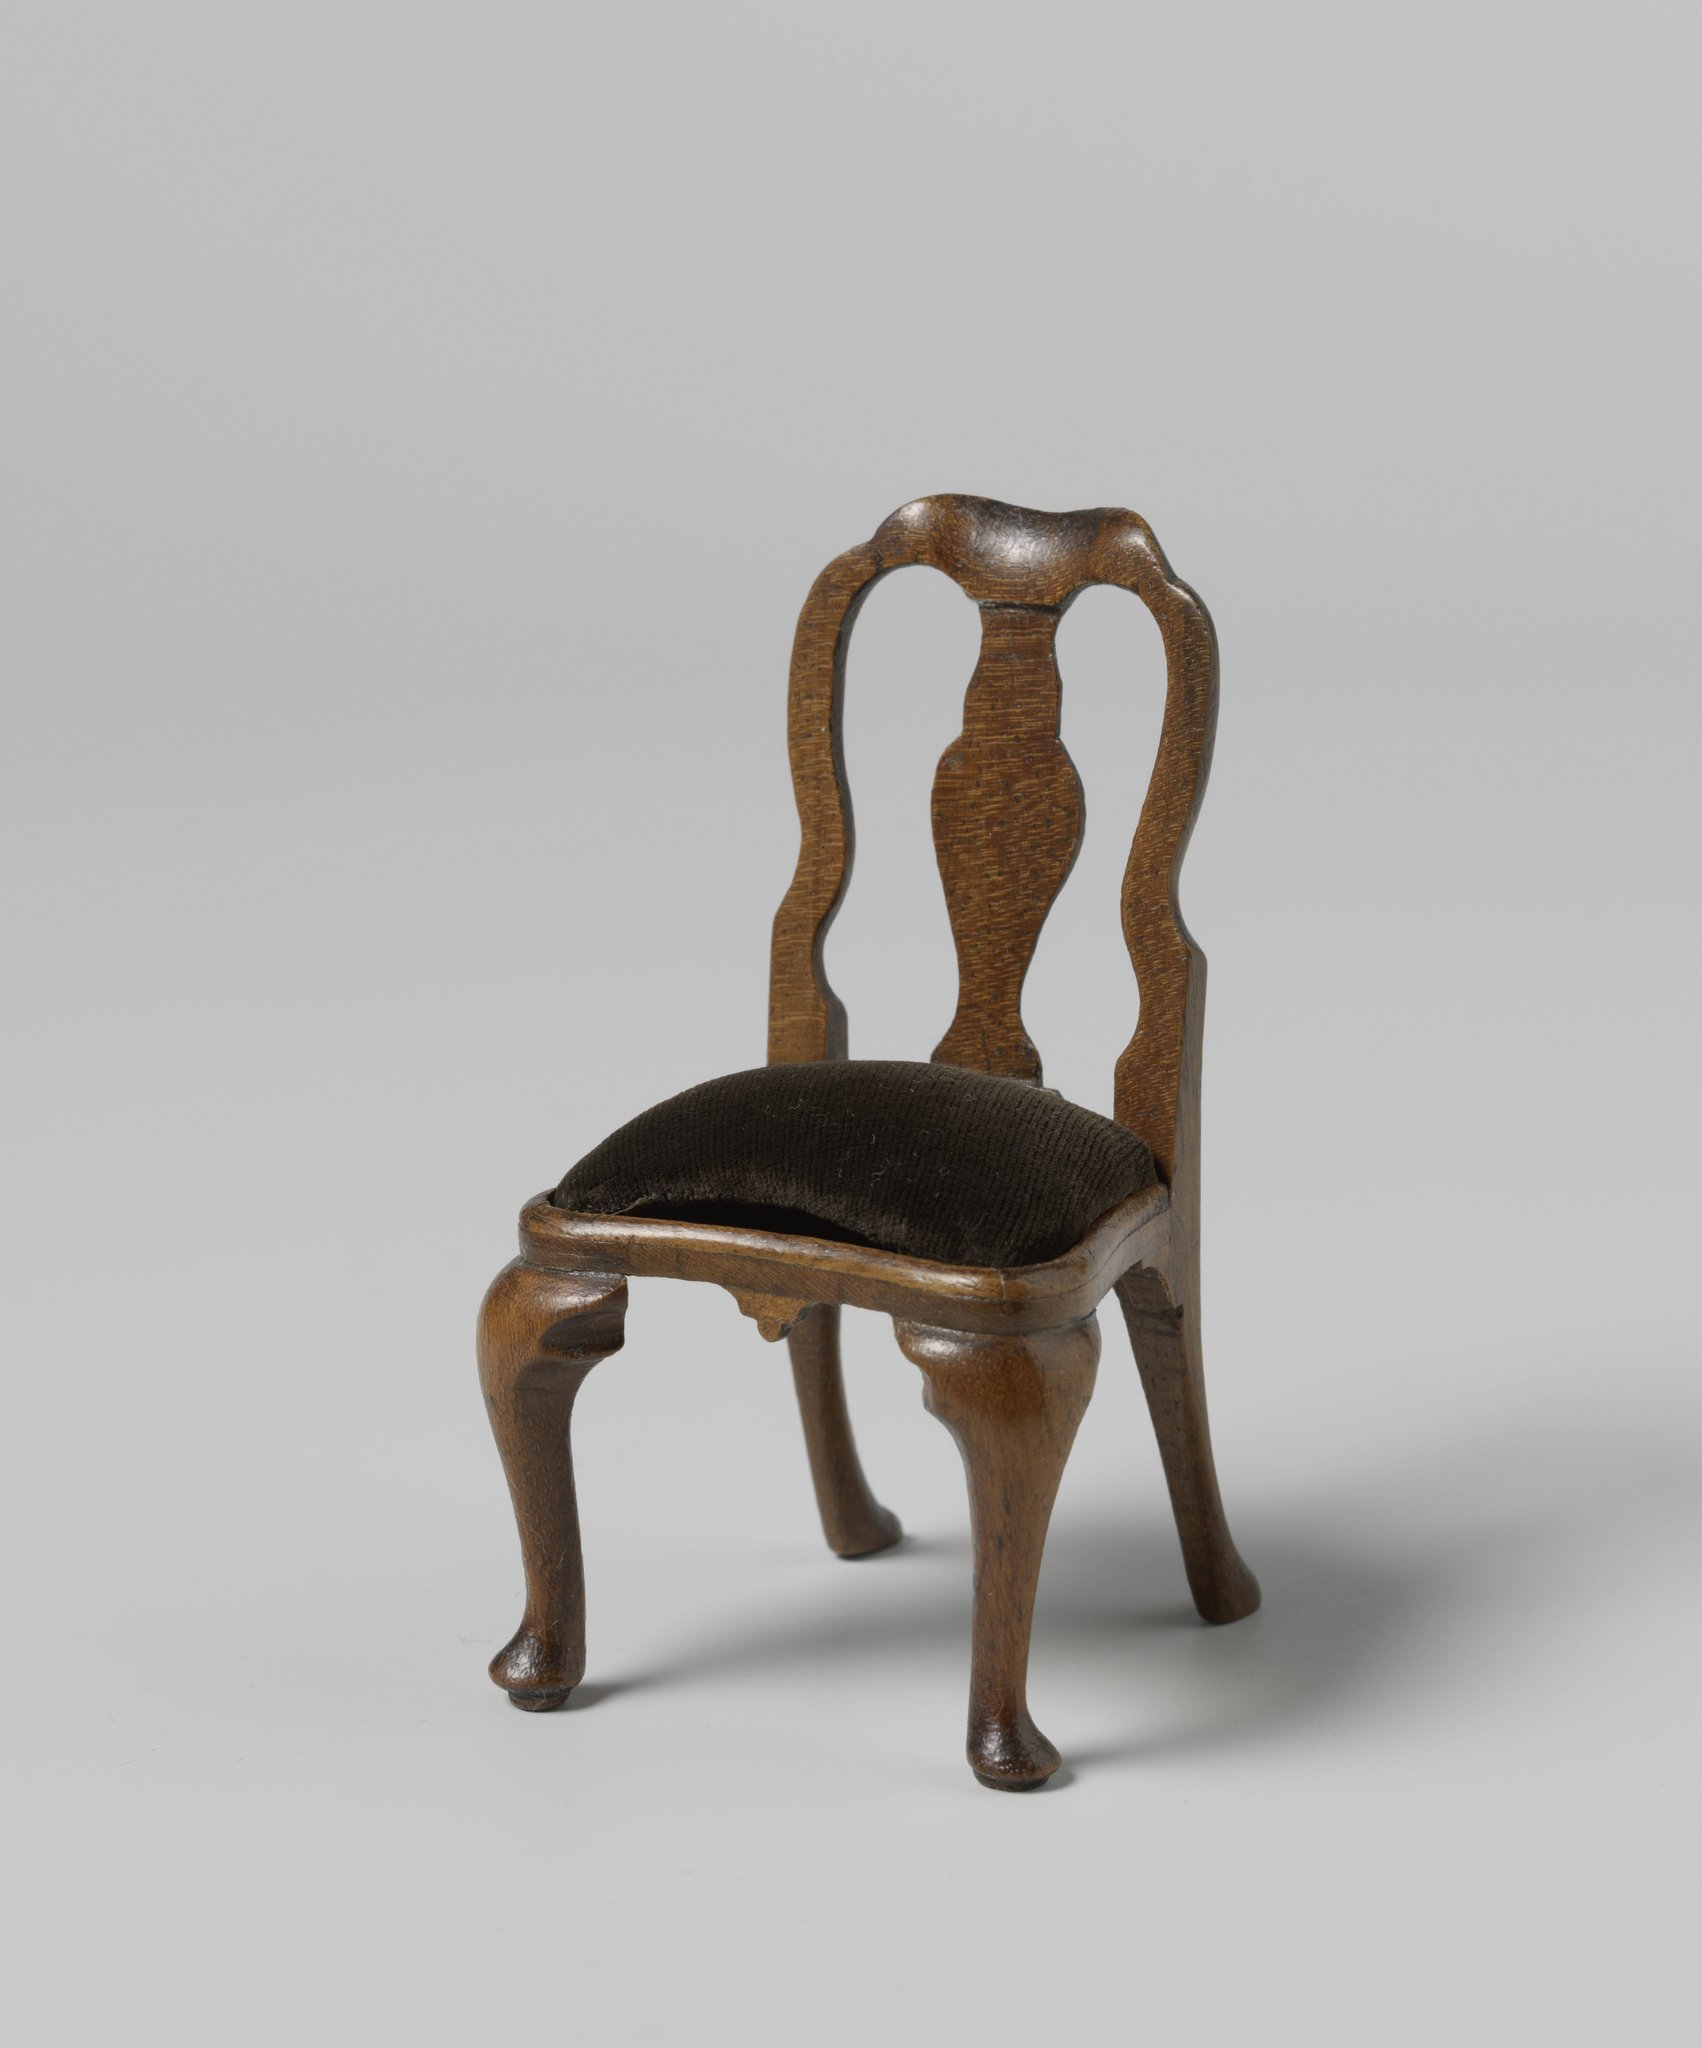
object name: chair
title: Stoel met open rugleuning met middenstijl, de zitting met groen fluweel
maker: Anonymous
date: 1750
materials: wood, velvet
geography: amsterdam